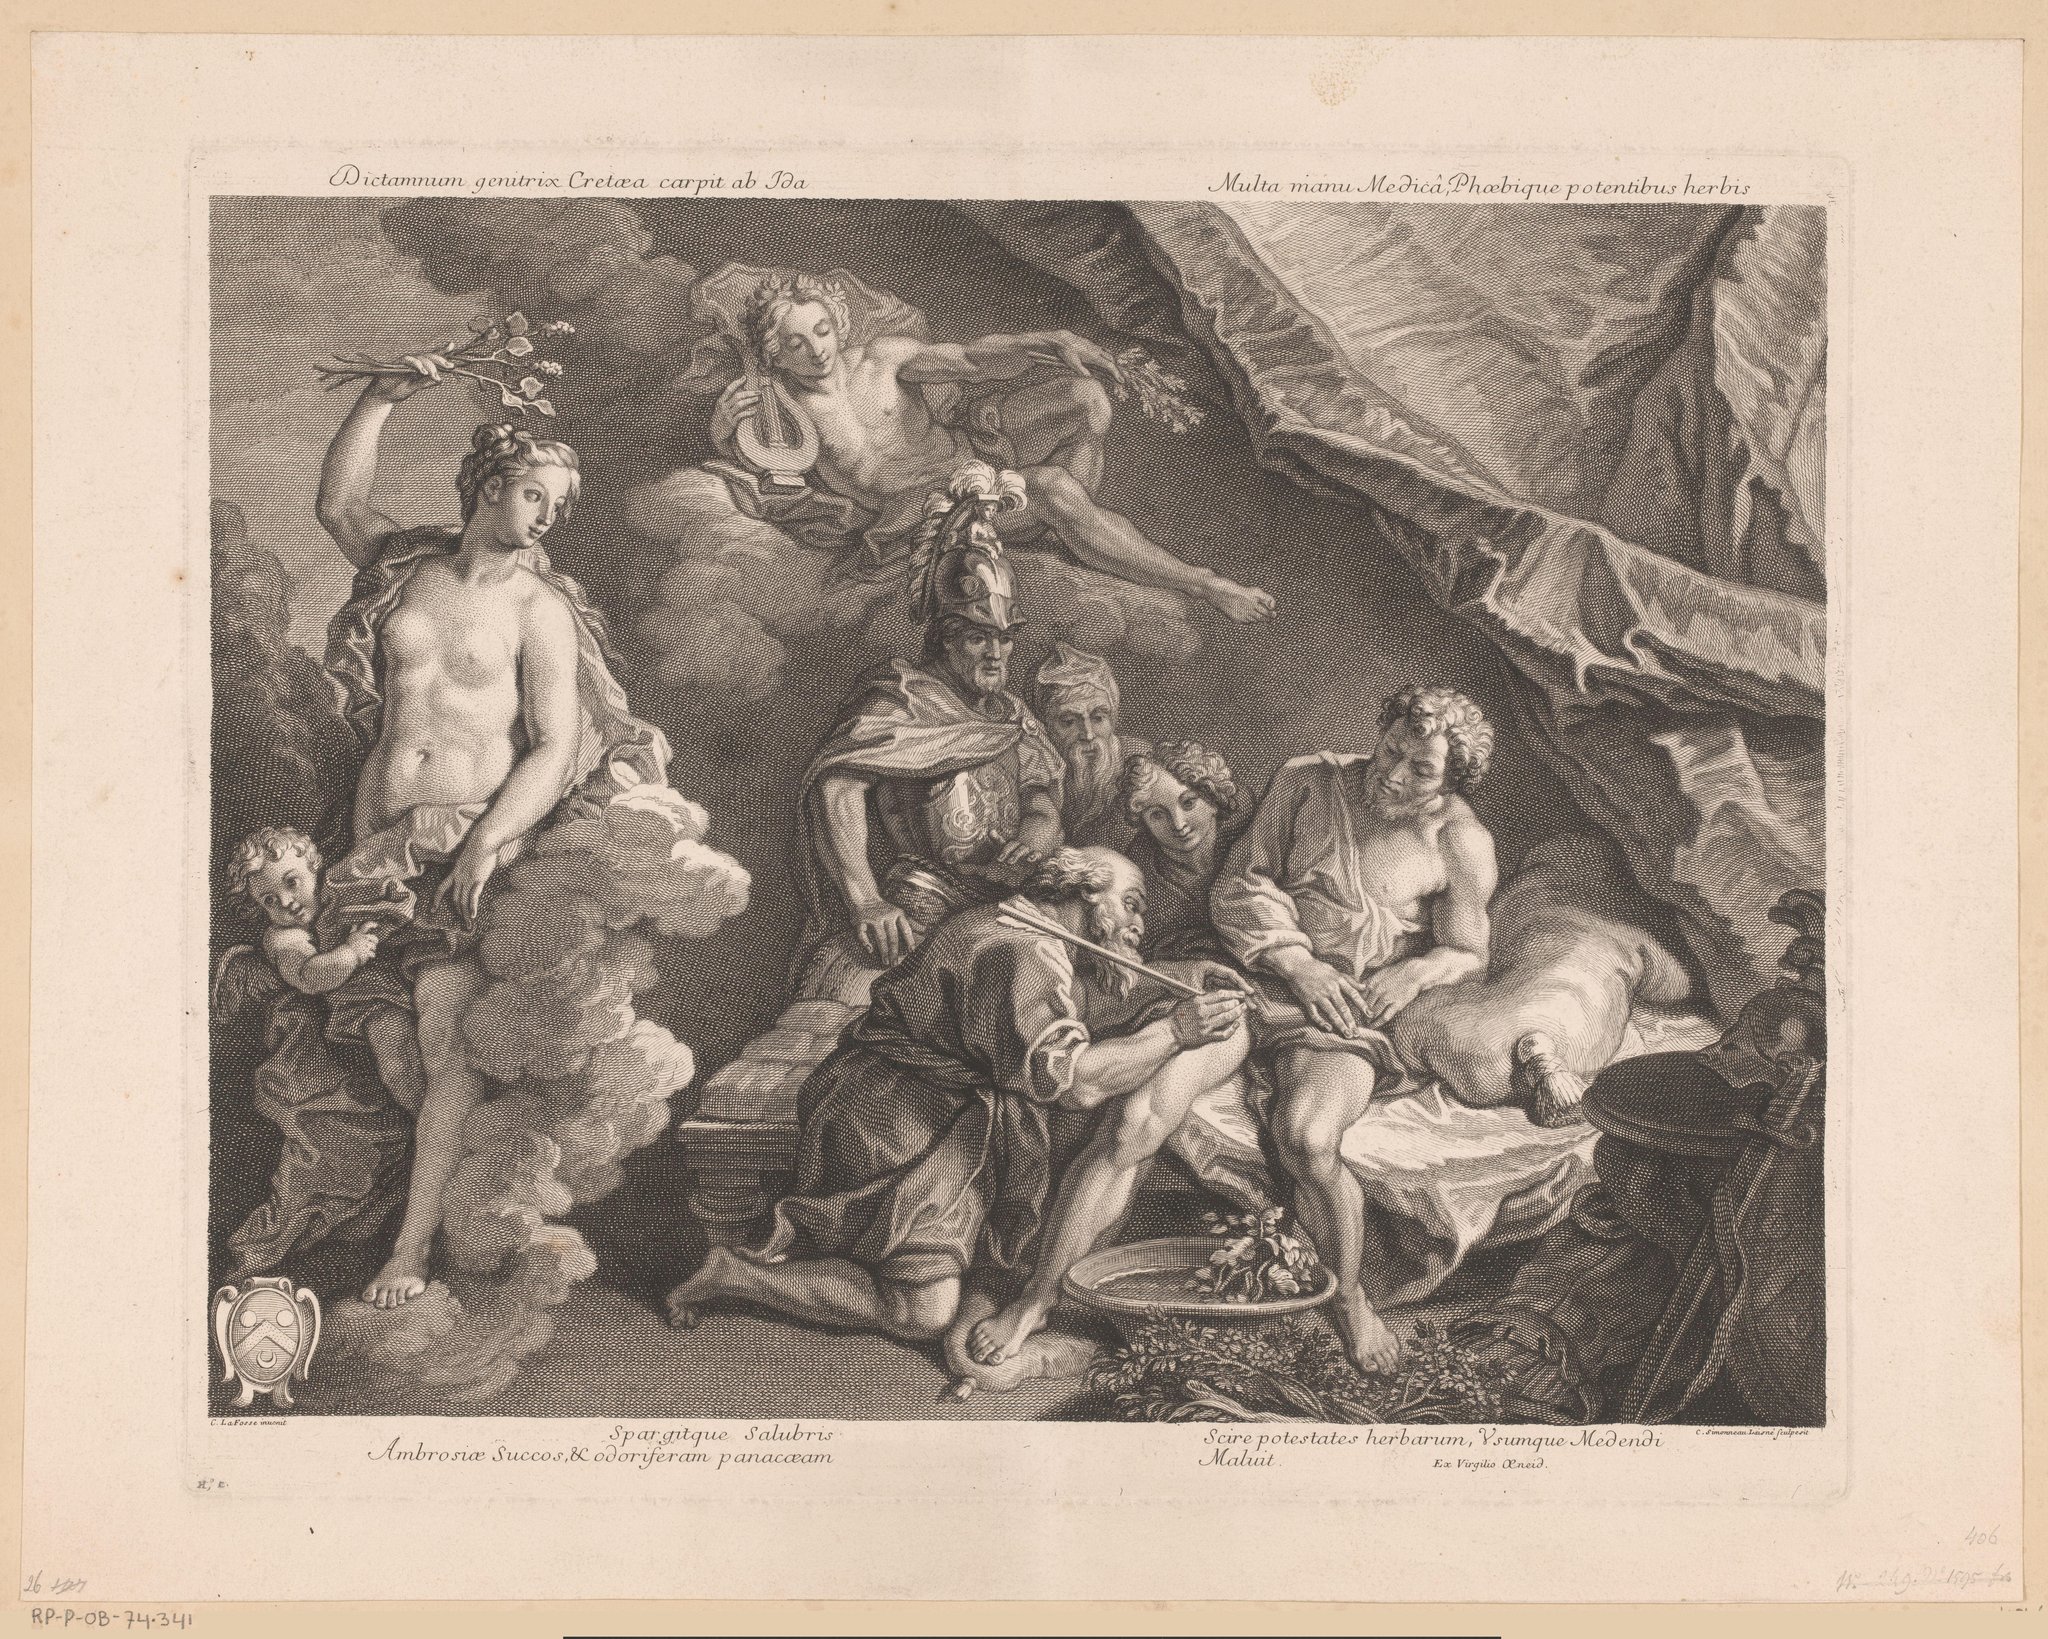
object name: print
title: Venus helpt Aeneas te genezen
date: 1655-1728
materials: paper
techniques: engraving, etching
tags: aeneas is wounded; venus secretly puts a healing plant in the water with which japyx is bathing the wound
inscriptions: collector's mark: Lugt 240